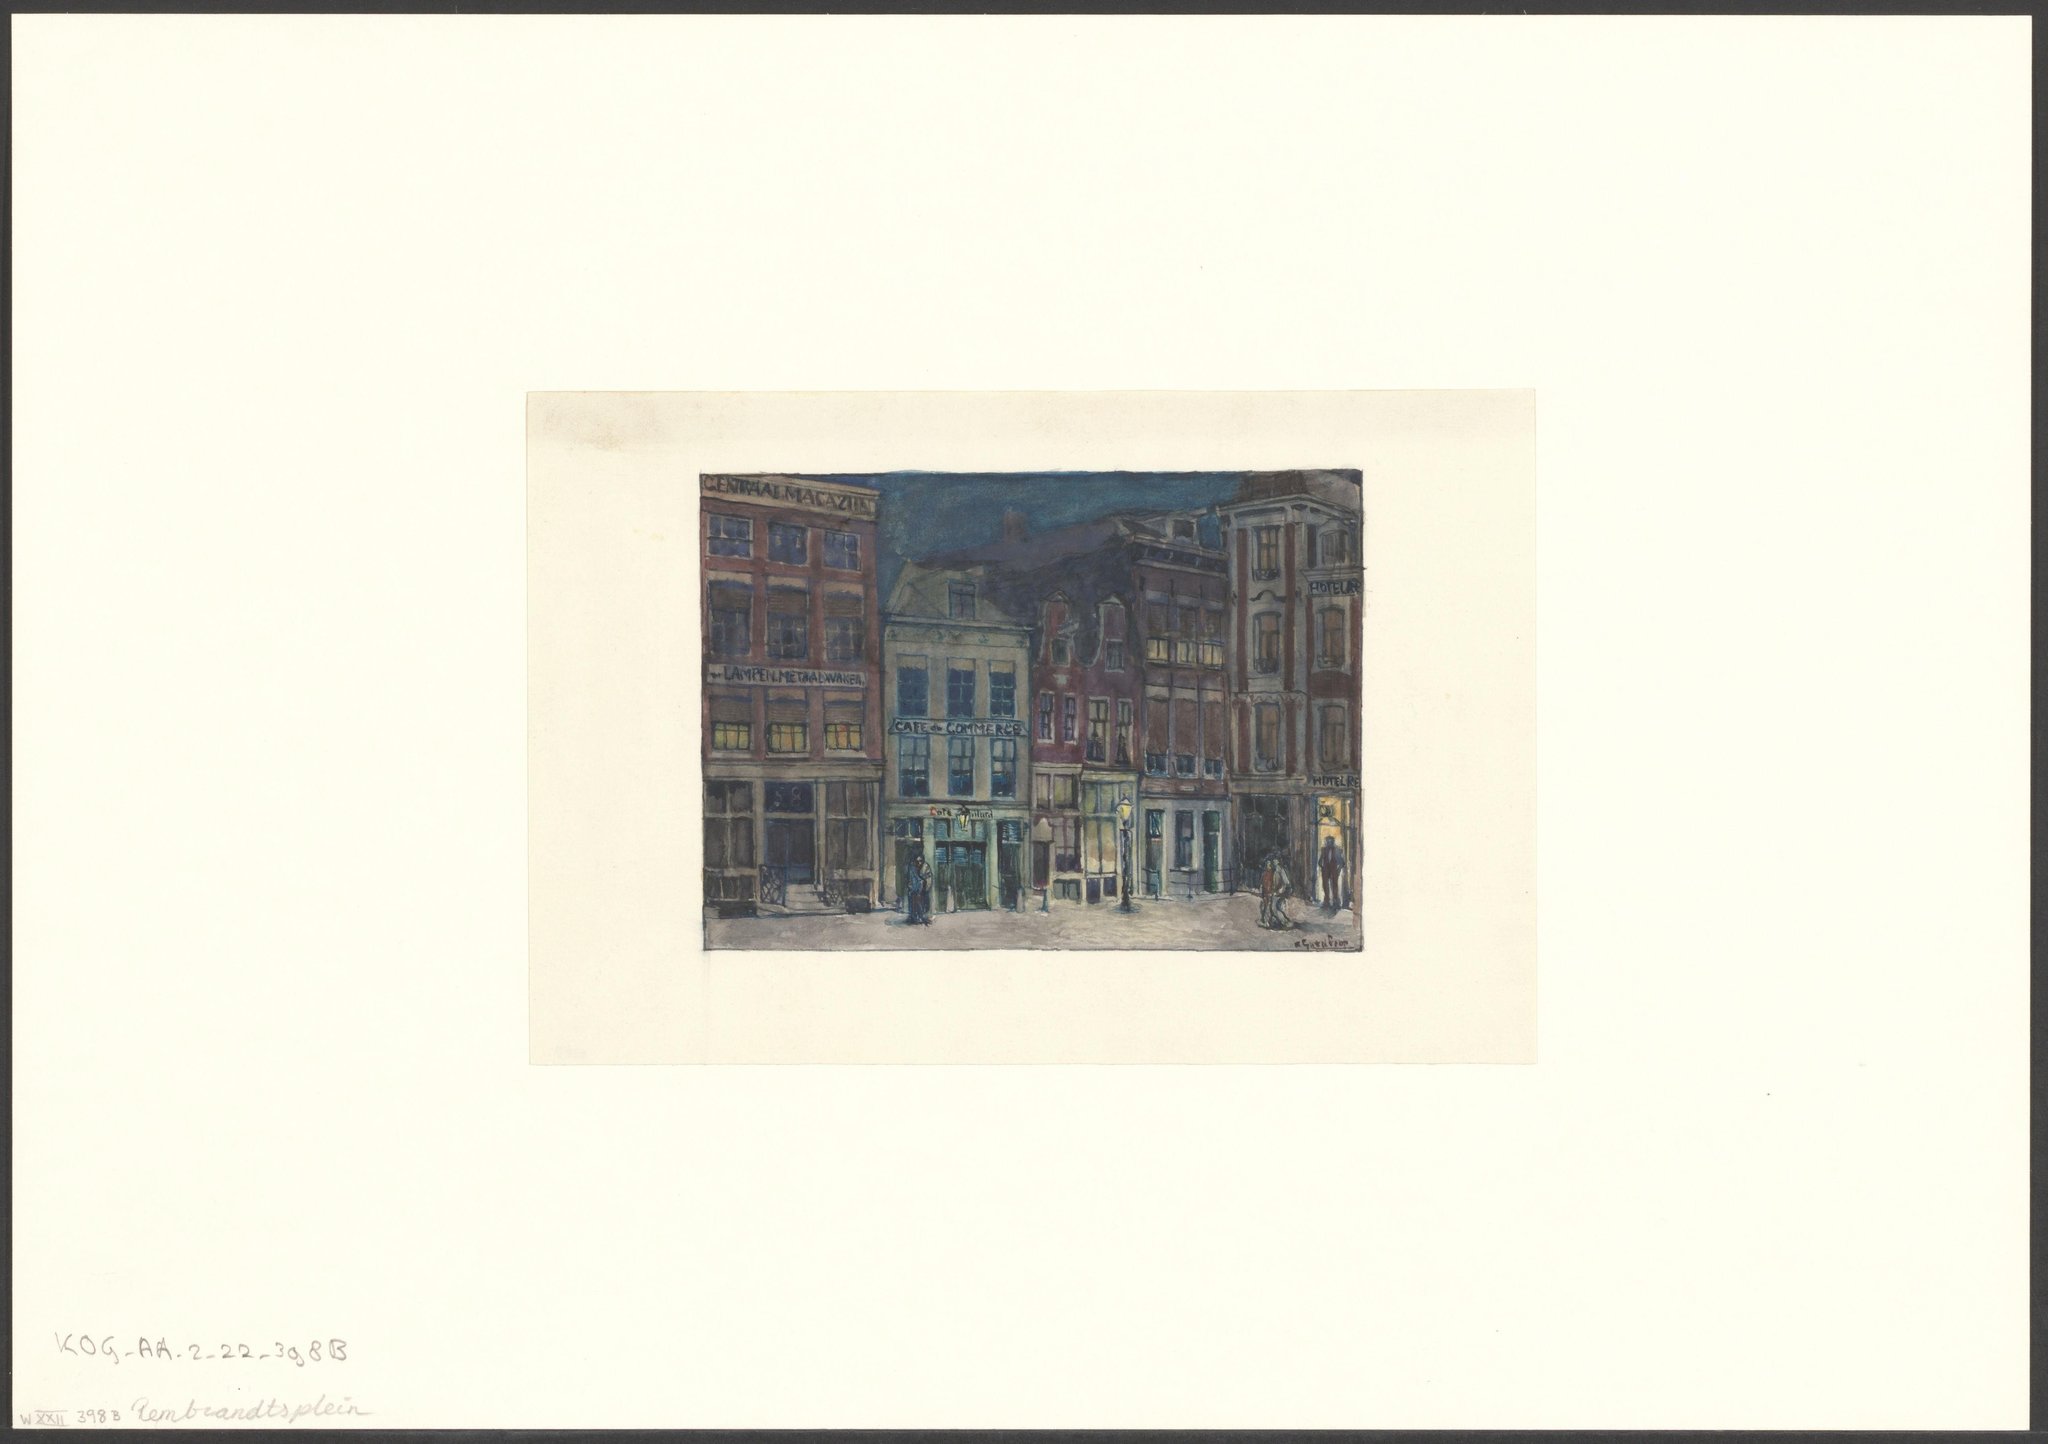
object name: drawing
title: Gezicht op het Rembrandtplein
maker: goedkoop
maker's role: draughtsman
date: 1876-1950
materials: paper, pencil, watercolor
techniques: brush, pen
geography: amsterdam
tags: square, place, circus, etc., city-view in general; 'veduta'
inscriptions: signature: ‘a goedkoop’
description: Tekening binnen de Atlas Van Eck ingedeeld op wijknummer 22.